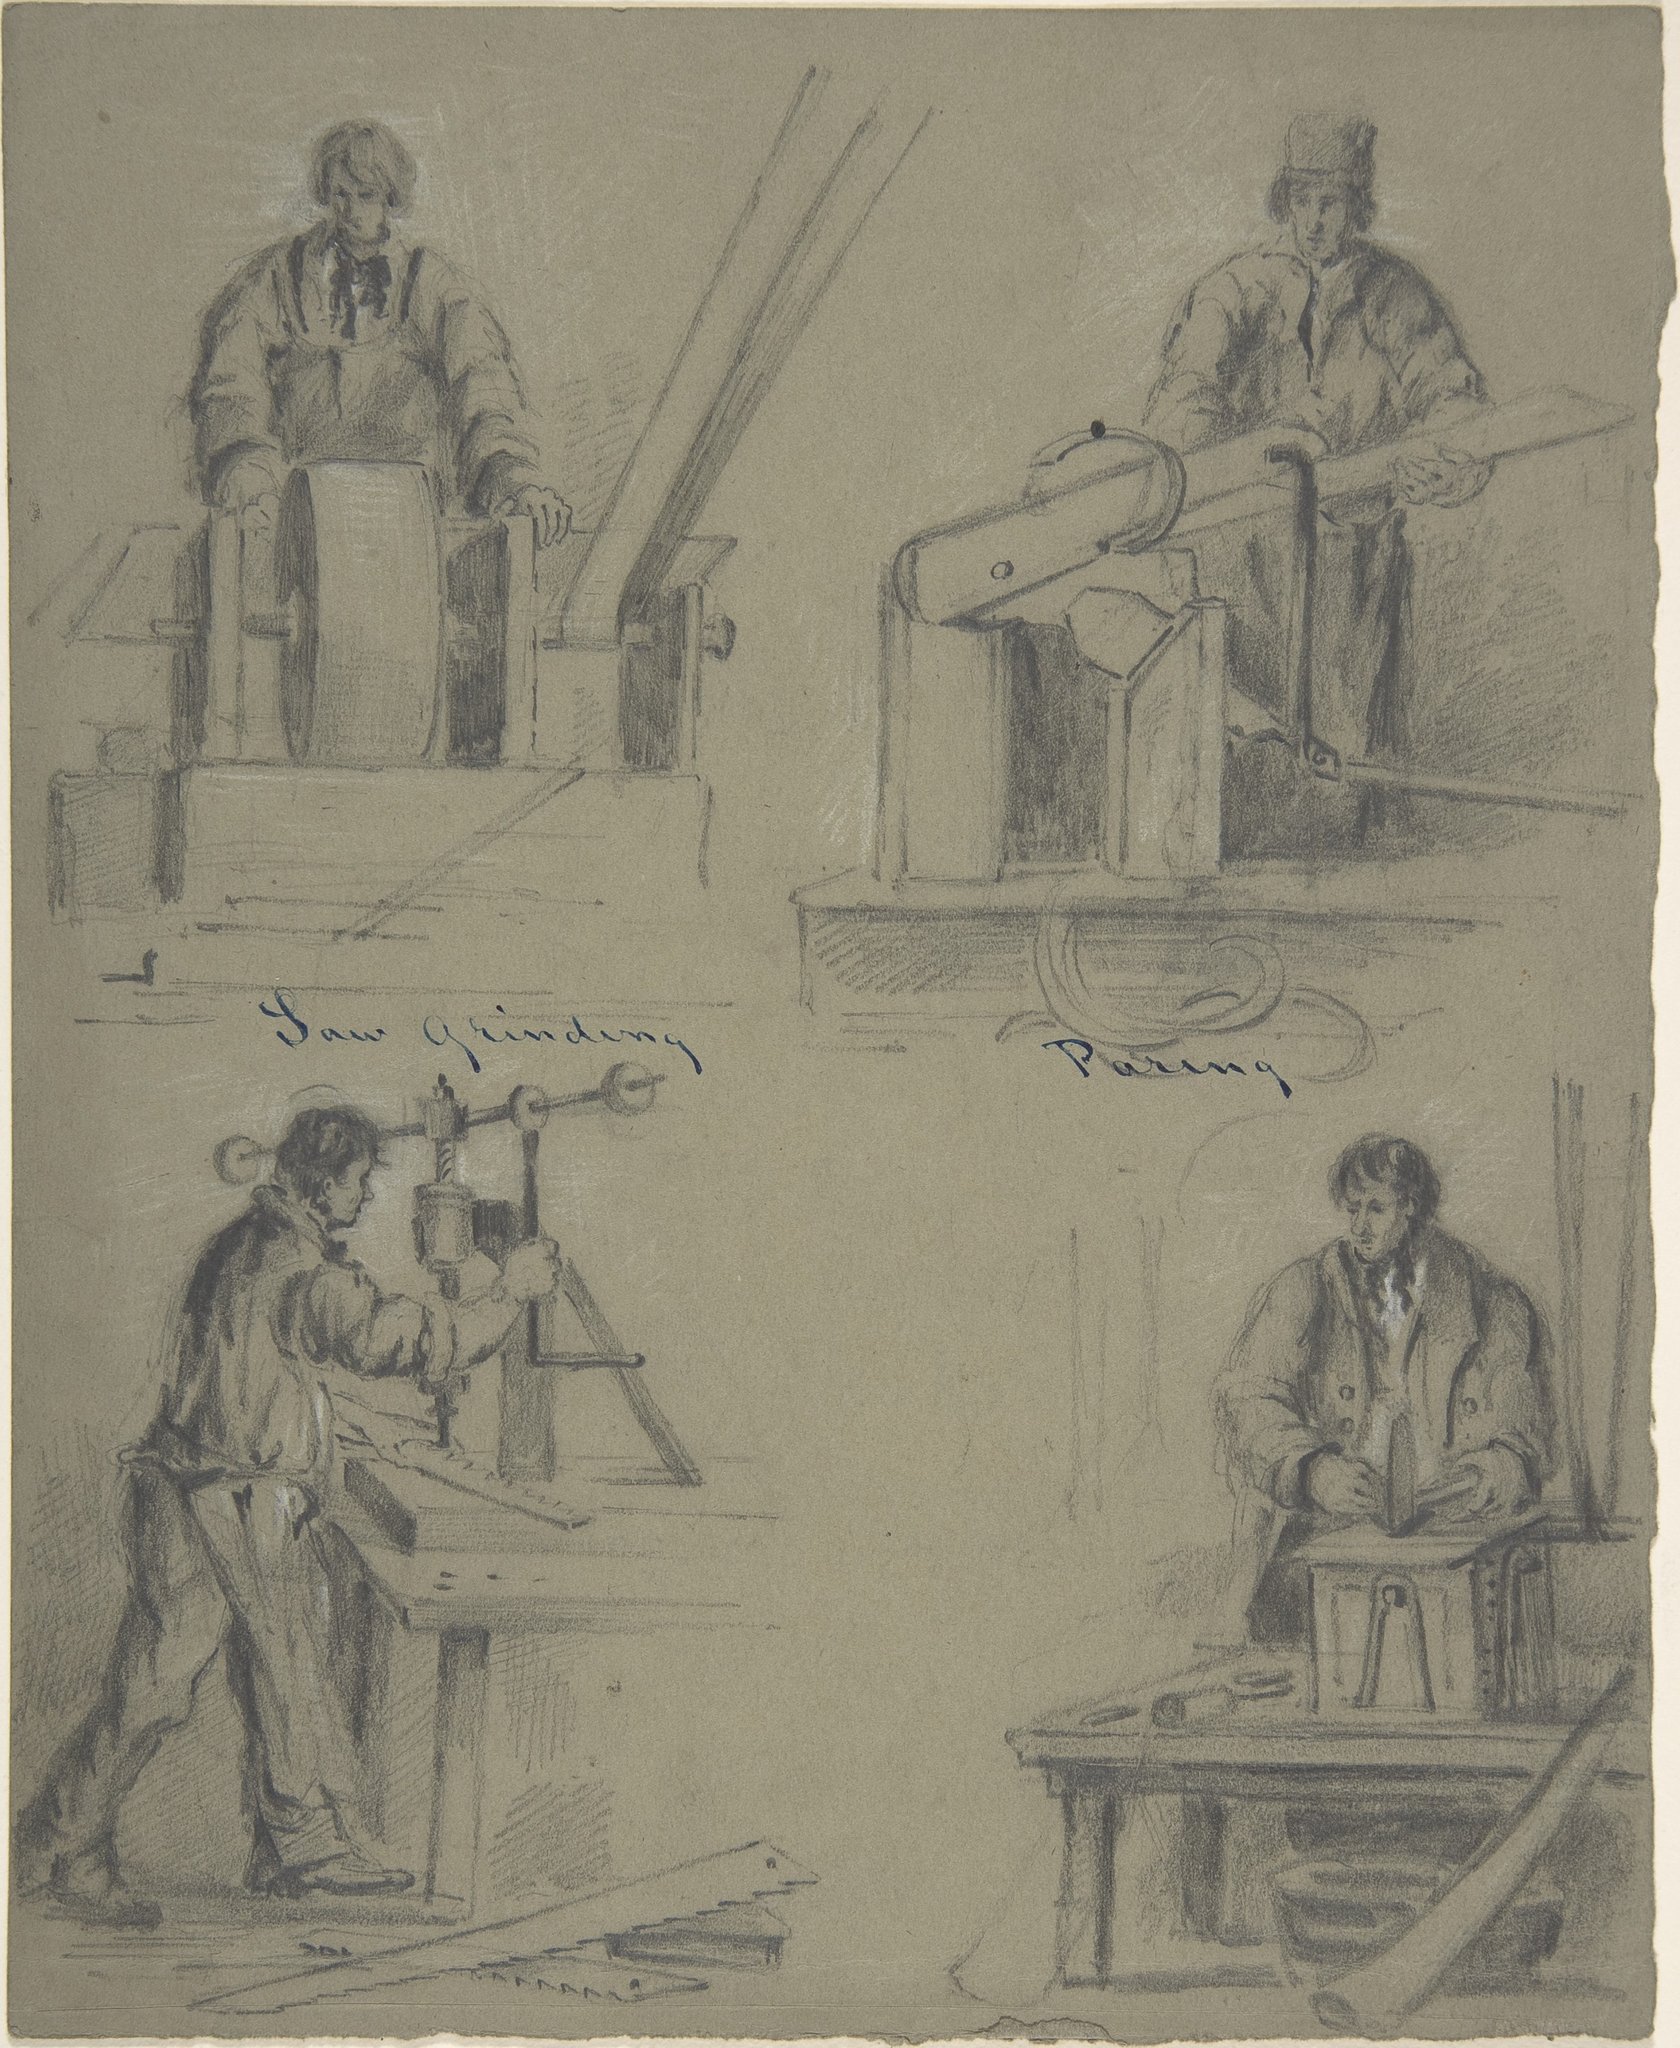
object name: drawing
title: Four drawings showing the manufacture of saws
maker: anonymous, british, 19th century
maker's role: artist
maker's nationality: british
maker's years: 1800-1900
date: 1801-1900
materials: chalk, graphite, ink, paper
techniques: pen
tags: men,working